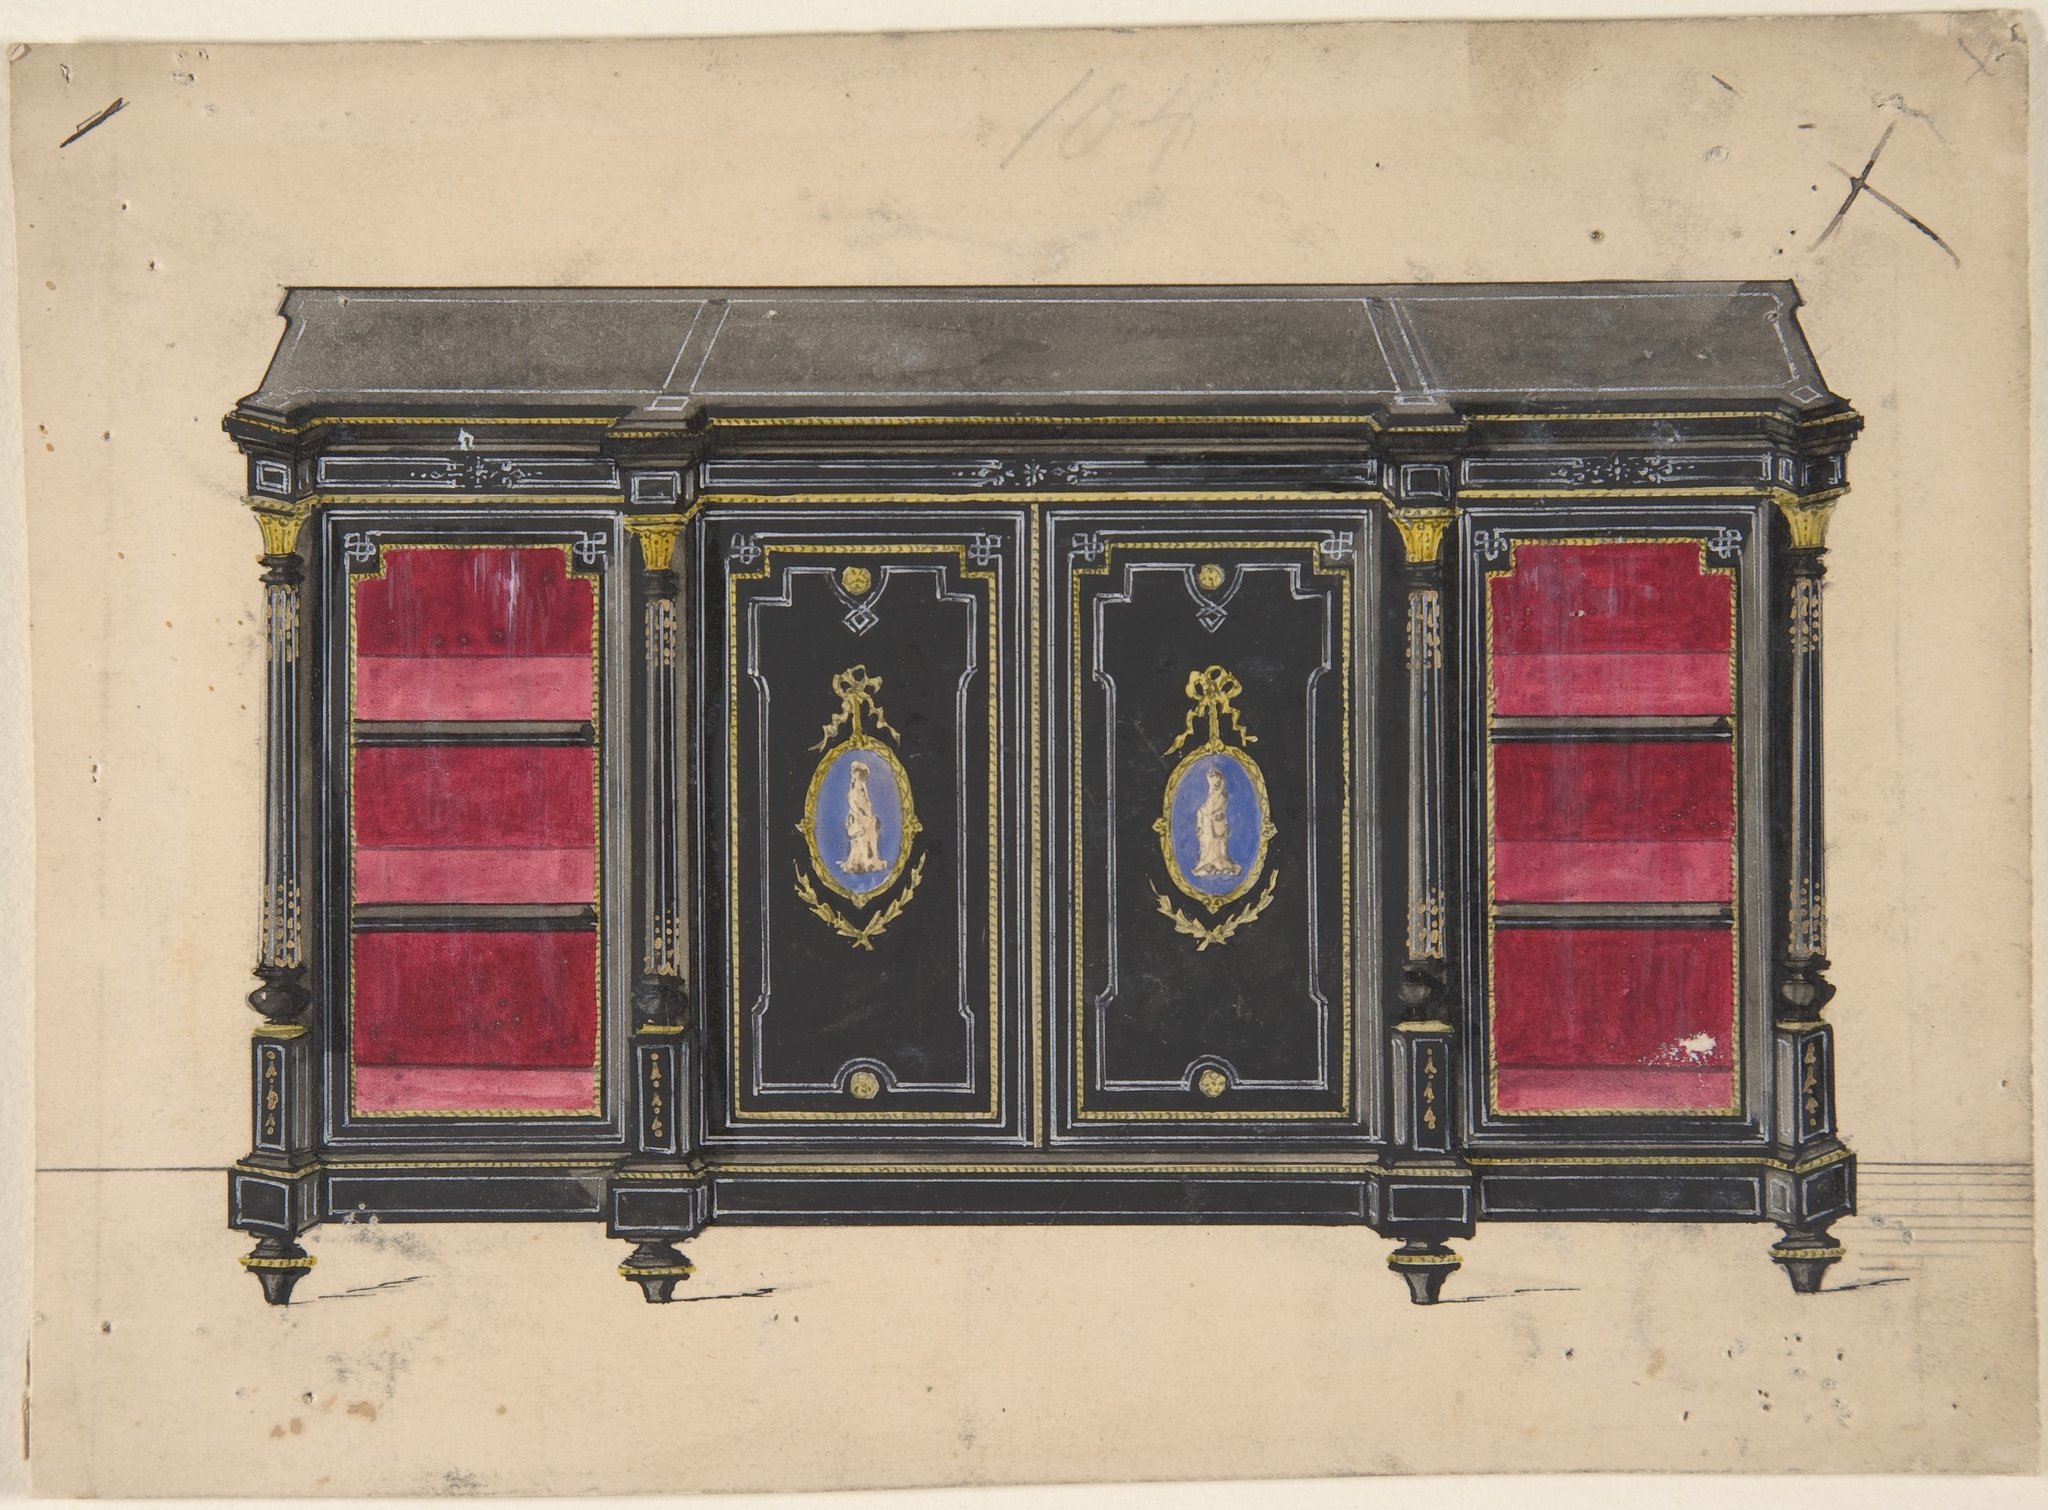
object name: drawing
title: Cabinet Design with Porcelain Plaques and Red Interior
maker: anonymous, british, 19th century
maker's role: artist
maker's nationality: british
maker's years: 1800-1900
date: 1801-1900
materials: ink, watercolor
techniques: pen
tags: cabinets